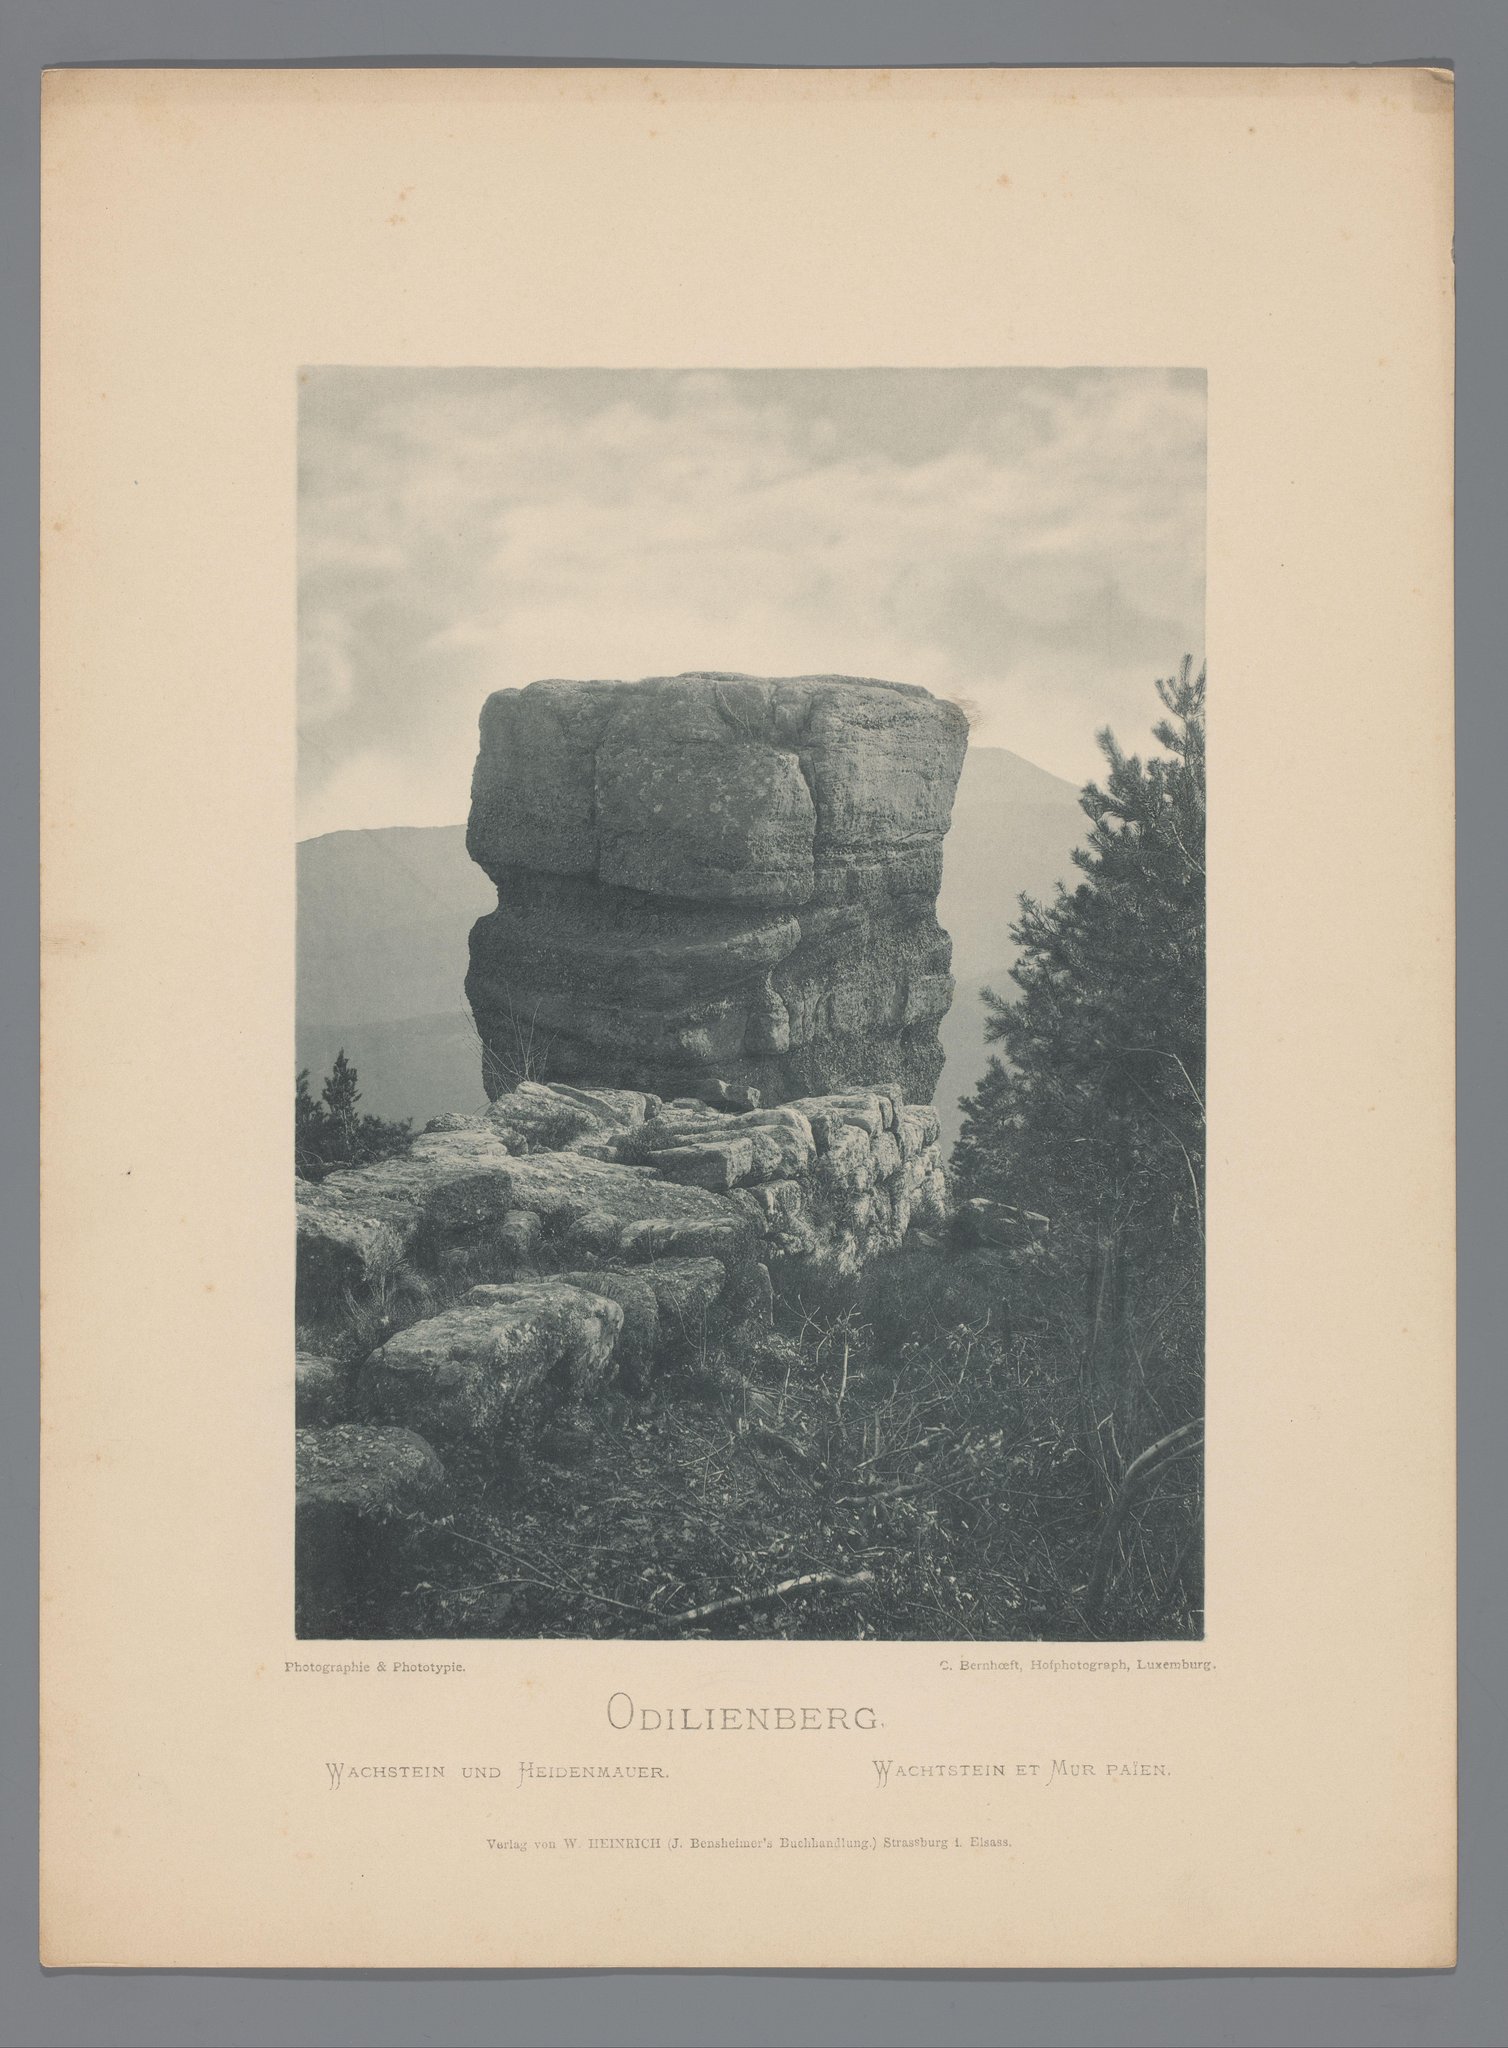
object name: photomechanical print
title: Odilienberg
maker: charles bernhoeft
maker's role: publisher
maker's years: 1859-1933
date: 1889-1894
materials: paper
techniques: photograph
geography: mont sainte-odile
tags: fence, wall, paling, boulder, stone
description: Deze prent maakt deel uit van een omslag met 100 prenten.